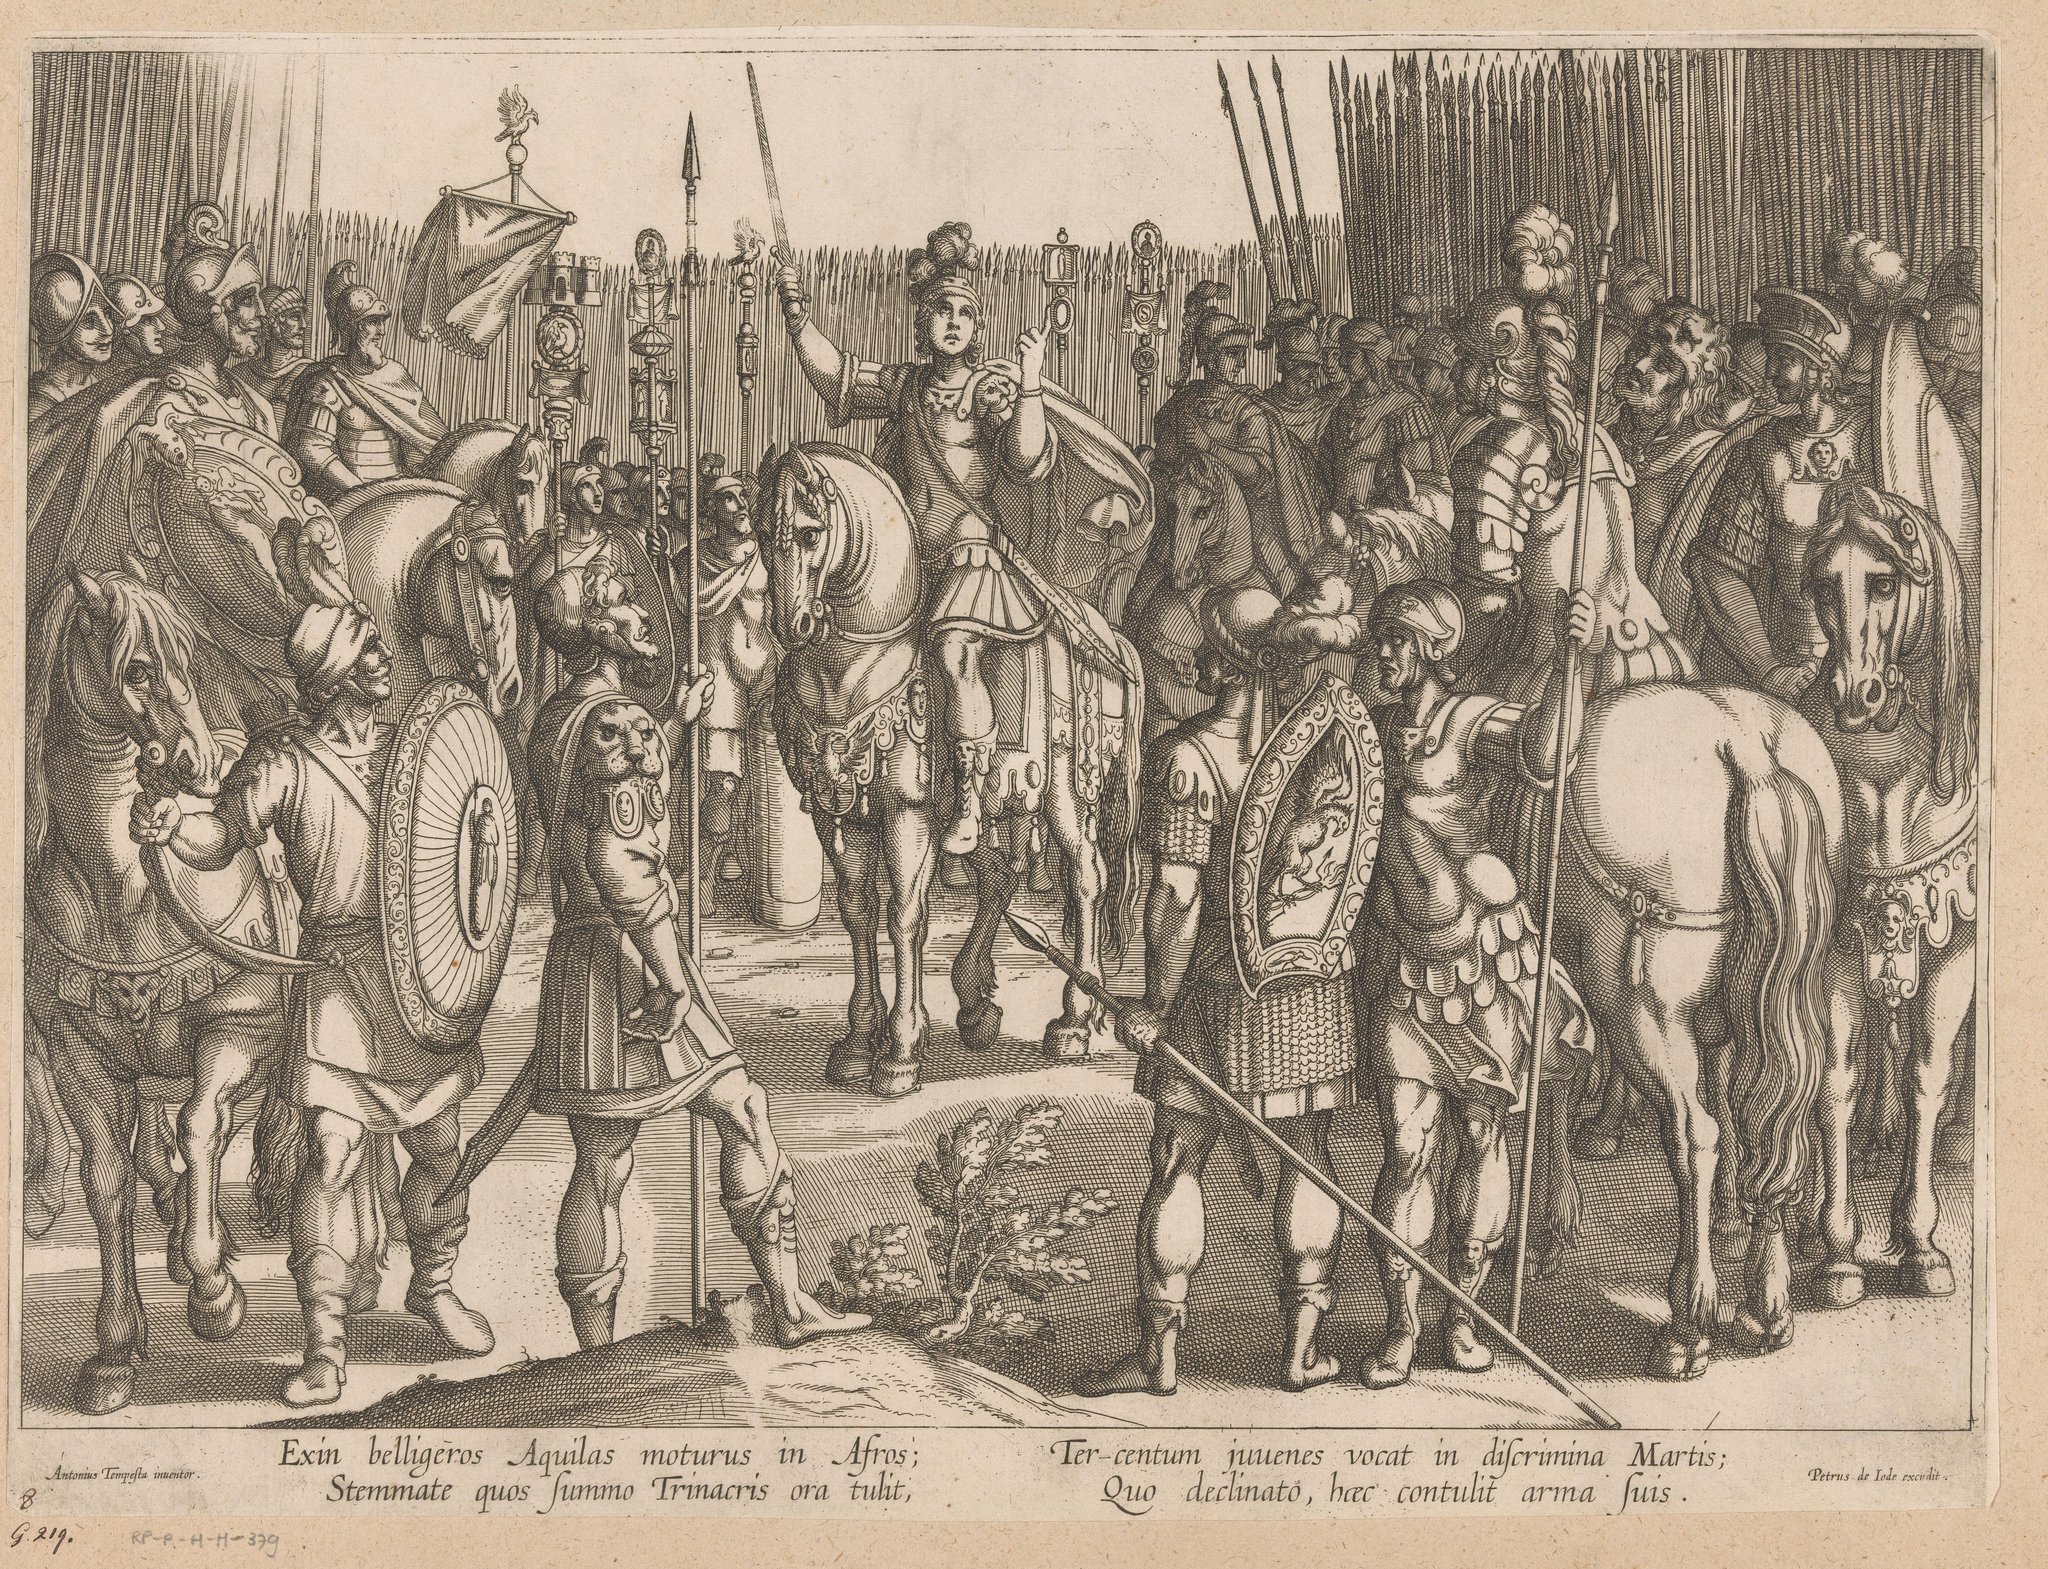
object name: print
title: Scipio Africanus spreekt zijn soldaten toe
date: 1620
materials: paper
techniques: etching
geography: italy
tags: politician, (story of) p. cornelius scipio africanus major, warfare; military affairs (+ cavalry, horsemen), the soldier; the soldier's life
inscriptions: number: ‘8’, collector's mark: ‘Hinloopen’, collector's mark: Lugt 11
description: Scipio Africanus zit te paard en wordt omringt door zijn soldaten met speren. Versregels in het Latijn in ondermarge.